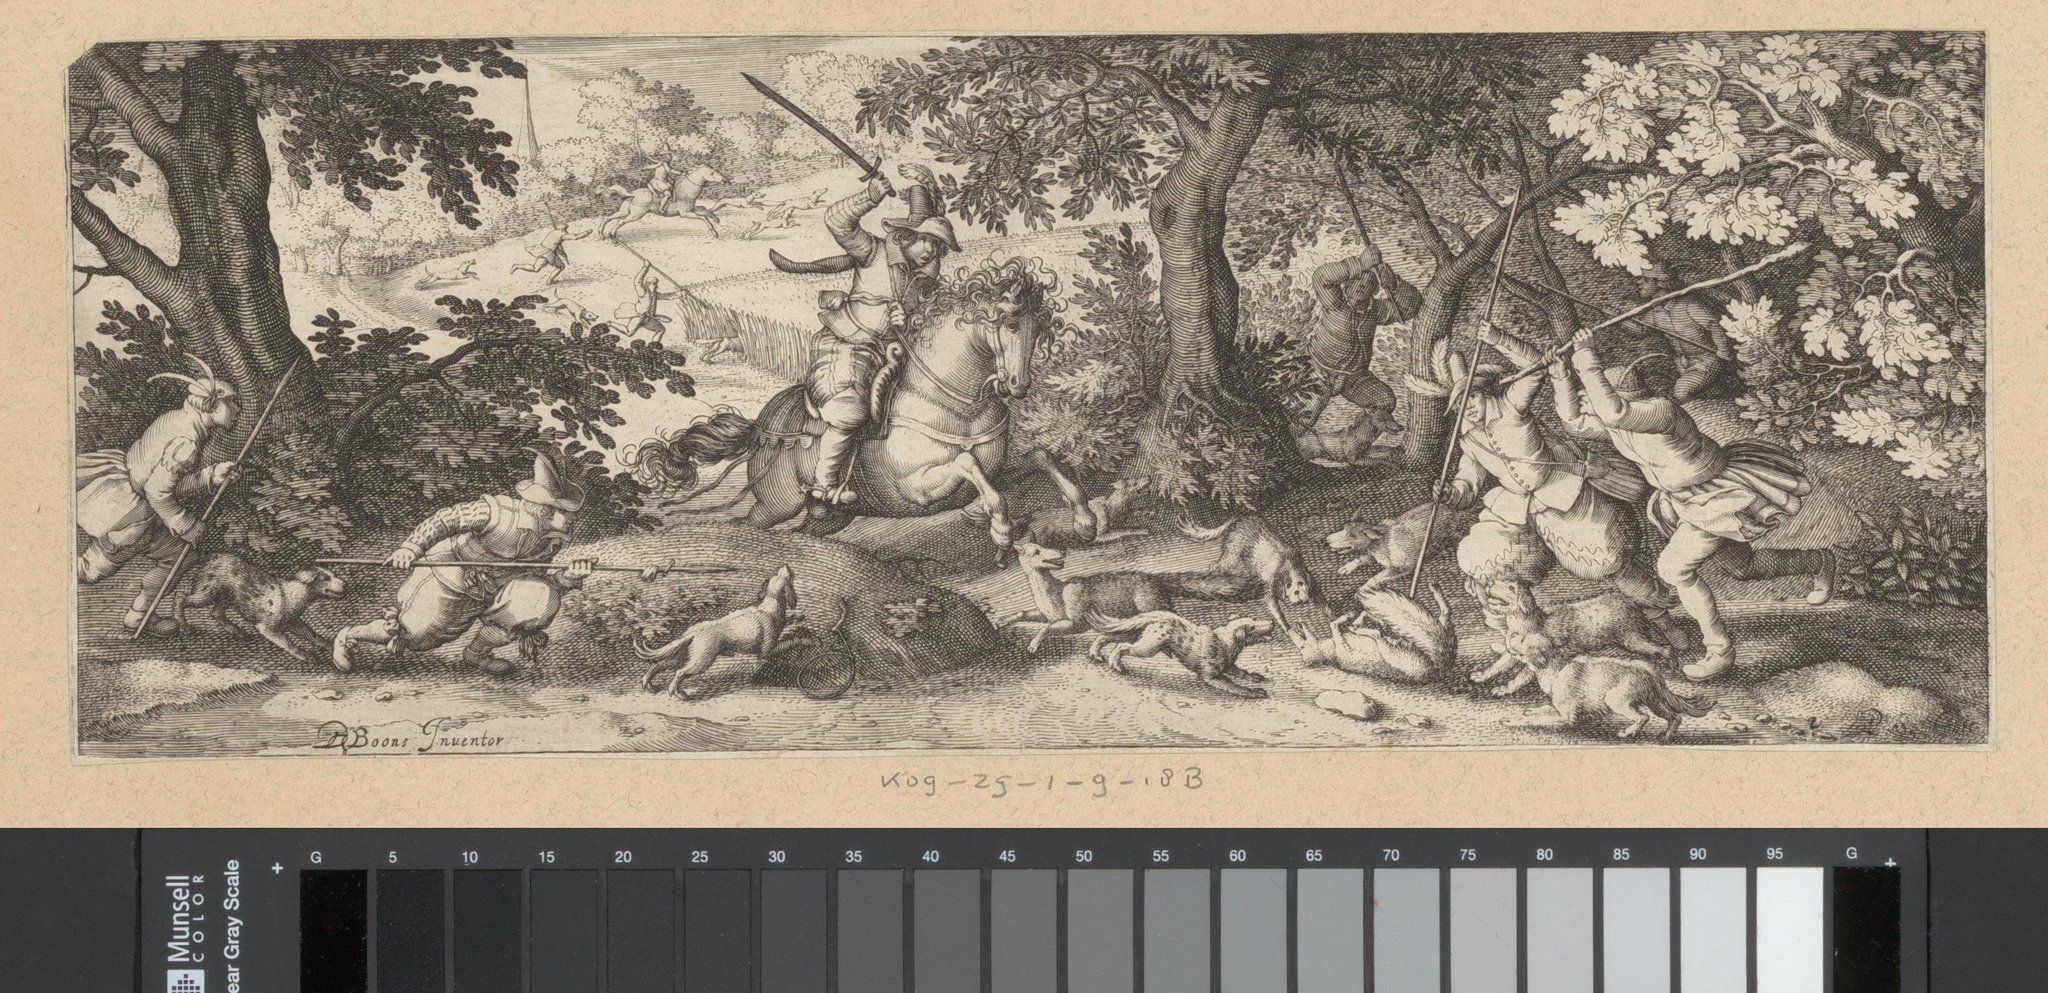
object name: print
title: Vossenjacht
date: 1612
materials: paper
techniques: engraving, etching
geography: amsterdam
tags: fox hunting, casting weapons: spear, the kill (~ hunting)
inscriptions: collector's mark: Lugt 1641, stamp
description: Een man te paard nadert met opgeheven zwaard een op zijn rug liggende vos, die door honden in het nauw is gedreven. Vier andere mannen rennen naar het dier toe met speren en knuppels: een van hen spietst de vos. Daarachter zit een vos vast door een strik om zijn lijf. Een man met een stok in de aanslag rent ernaartoe. Op de achtergrond een drijfjacht. Onderwerpsrubrieken binnen de Atlas Zeden en Gewoonten: Handel, nijverheid en verkeer, jacht.